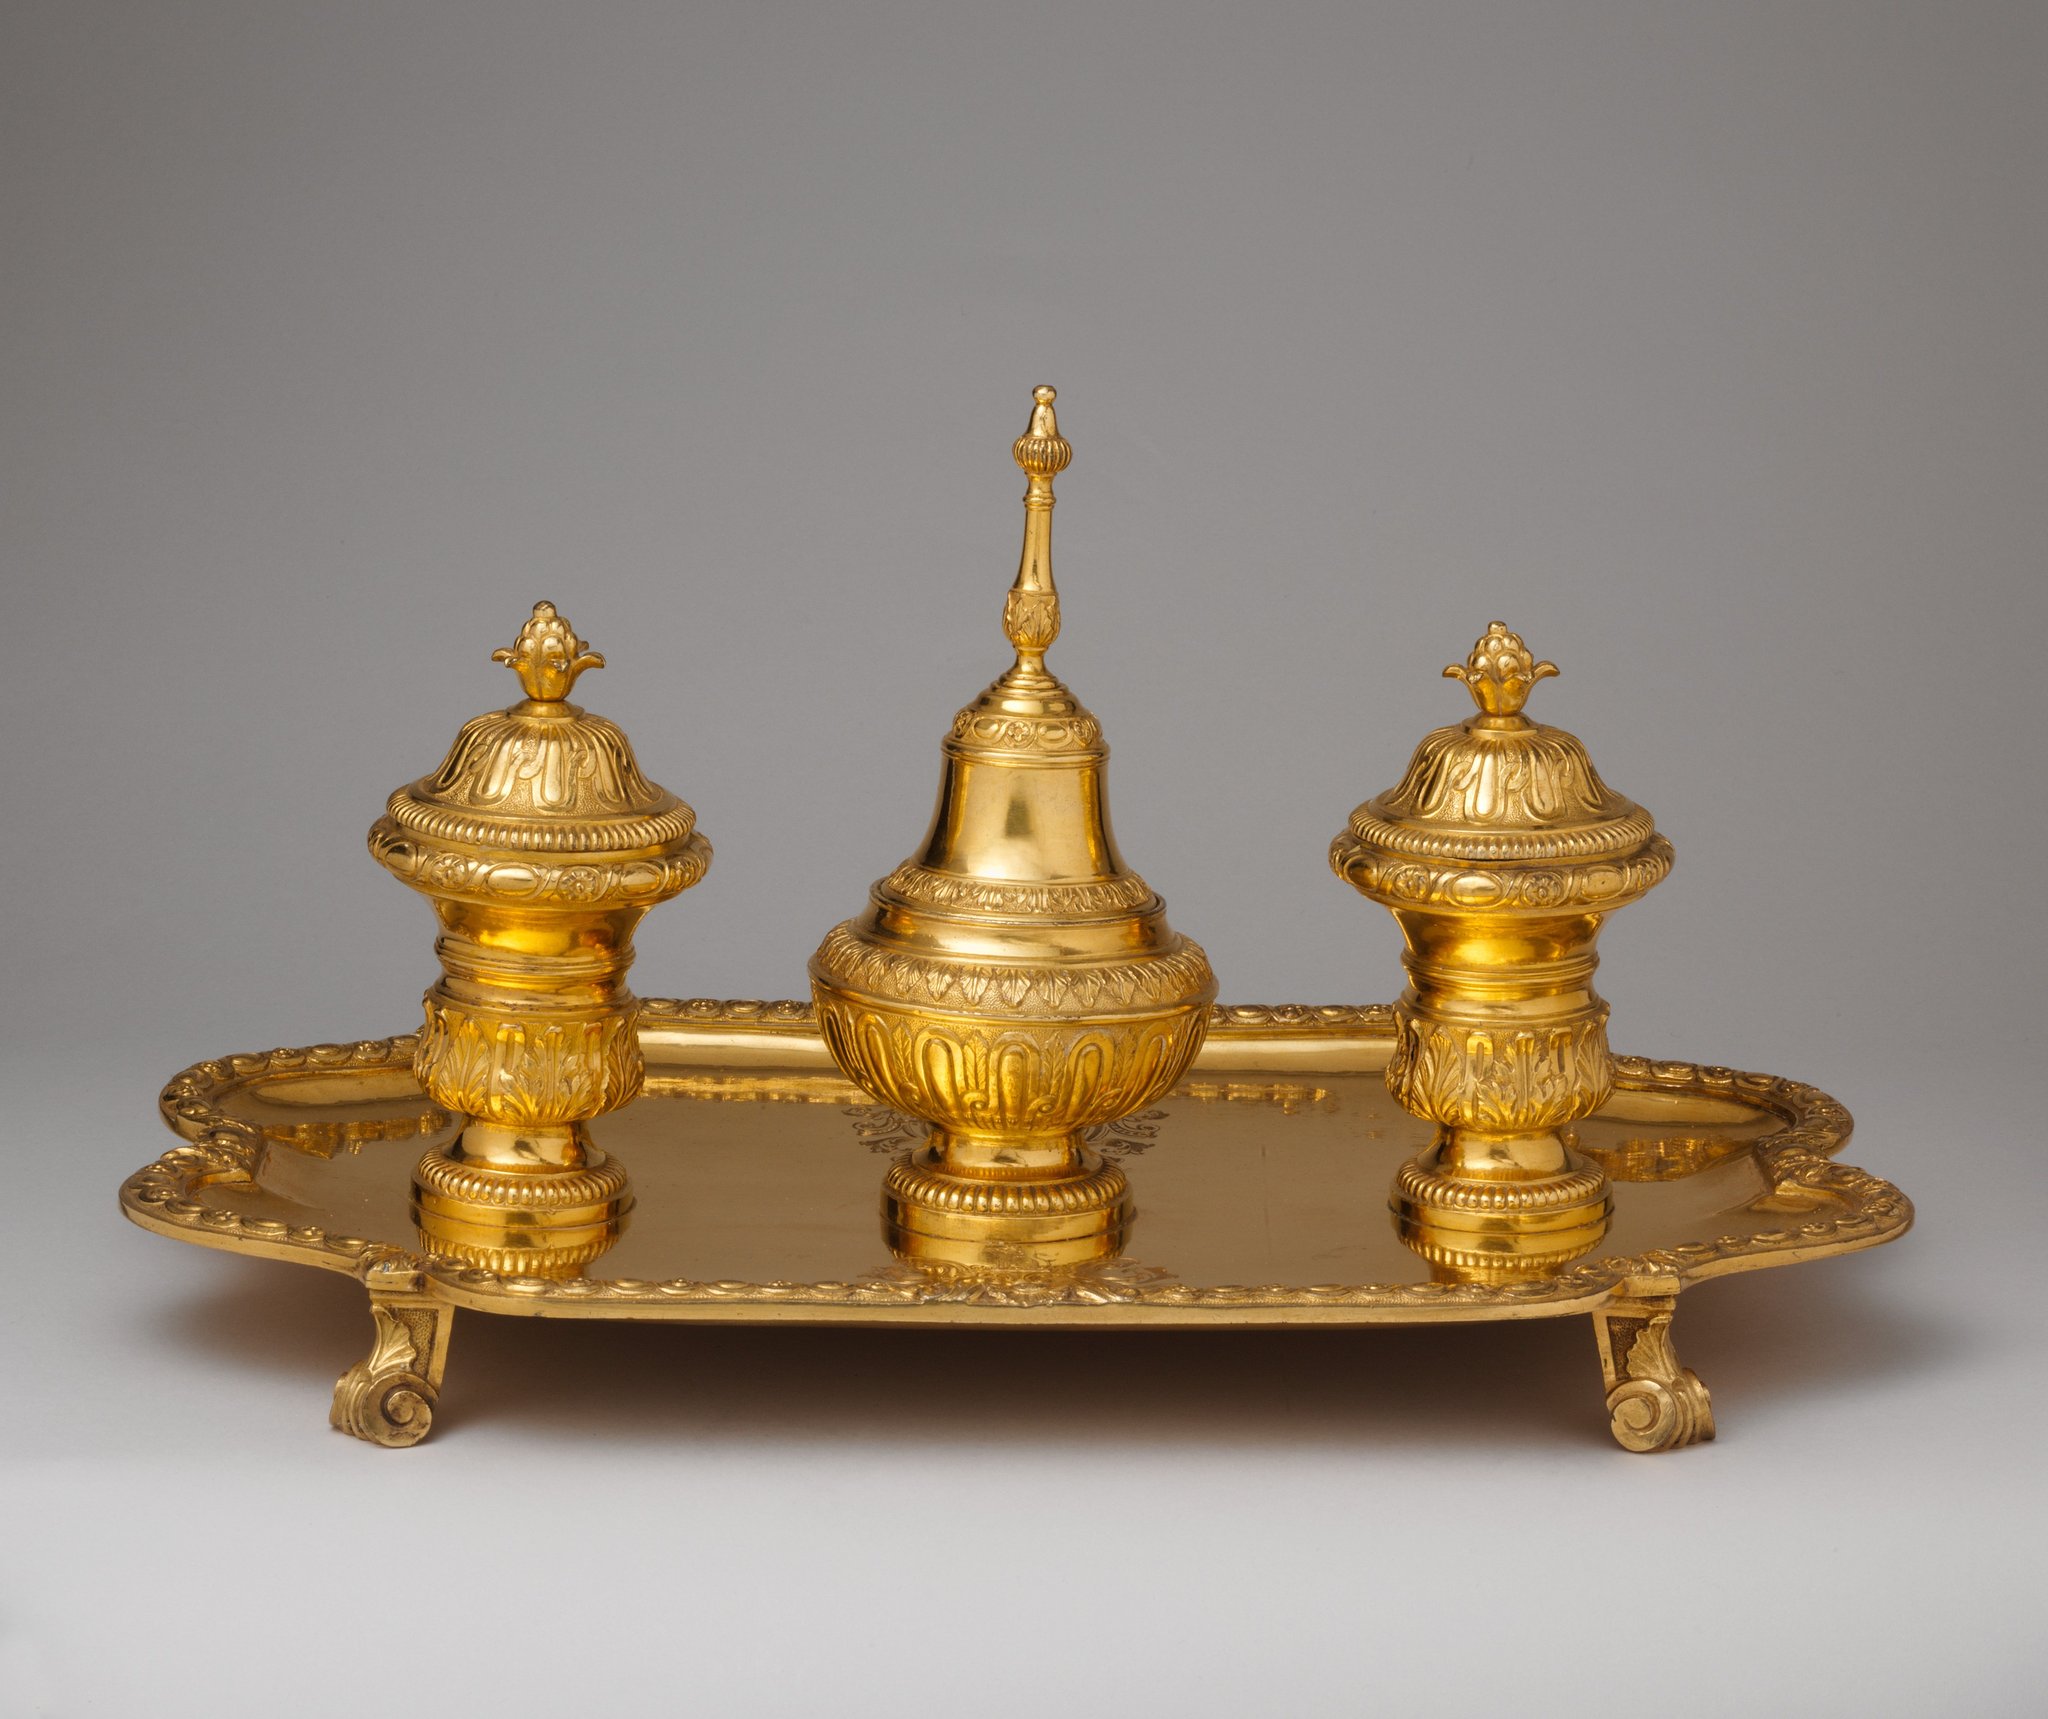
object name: inkstand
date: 1730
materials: gilt bronze